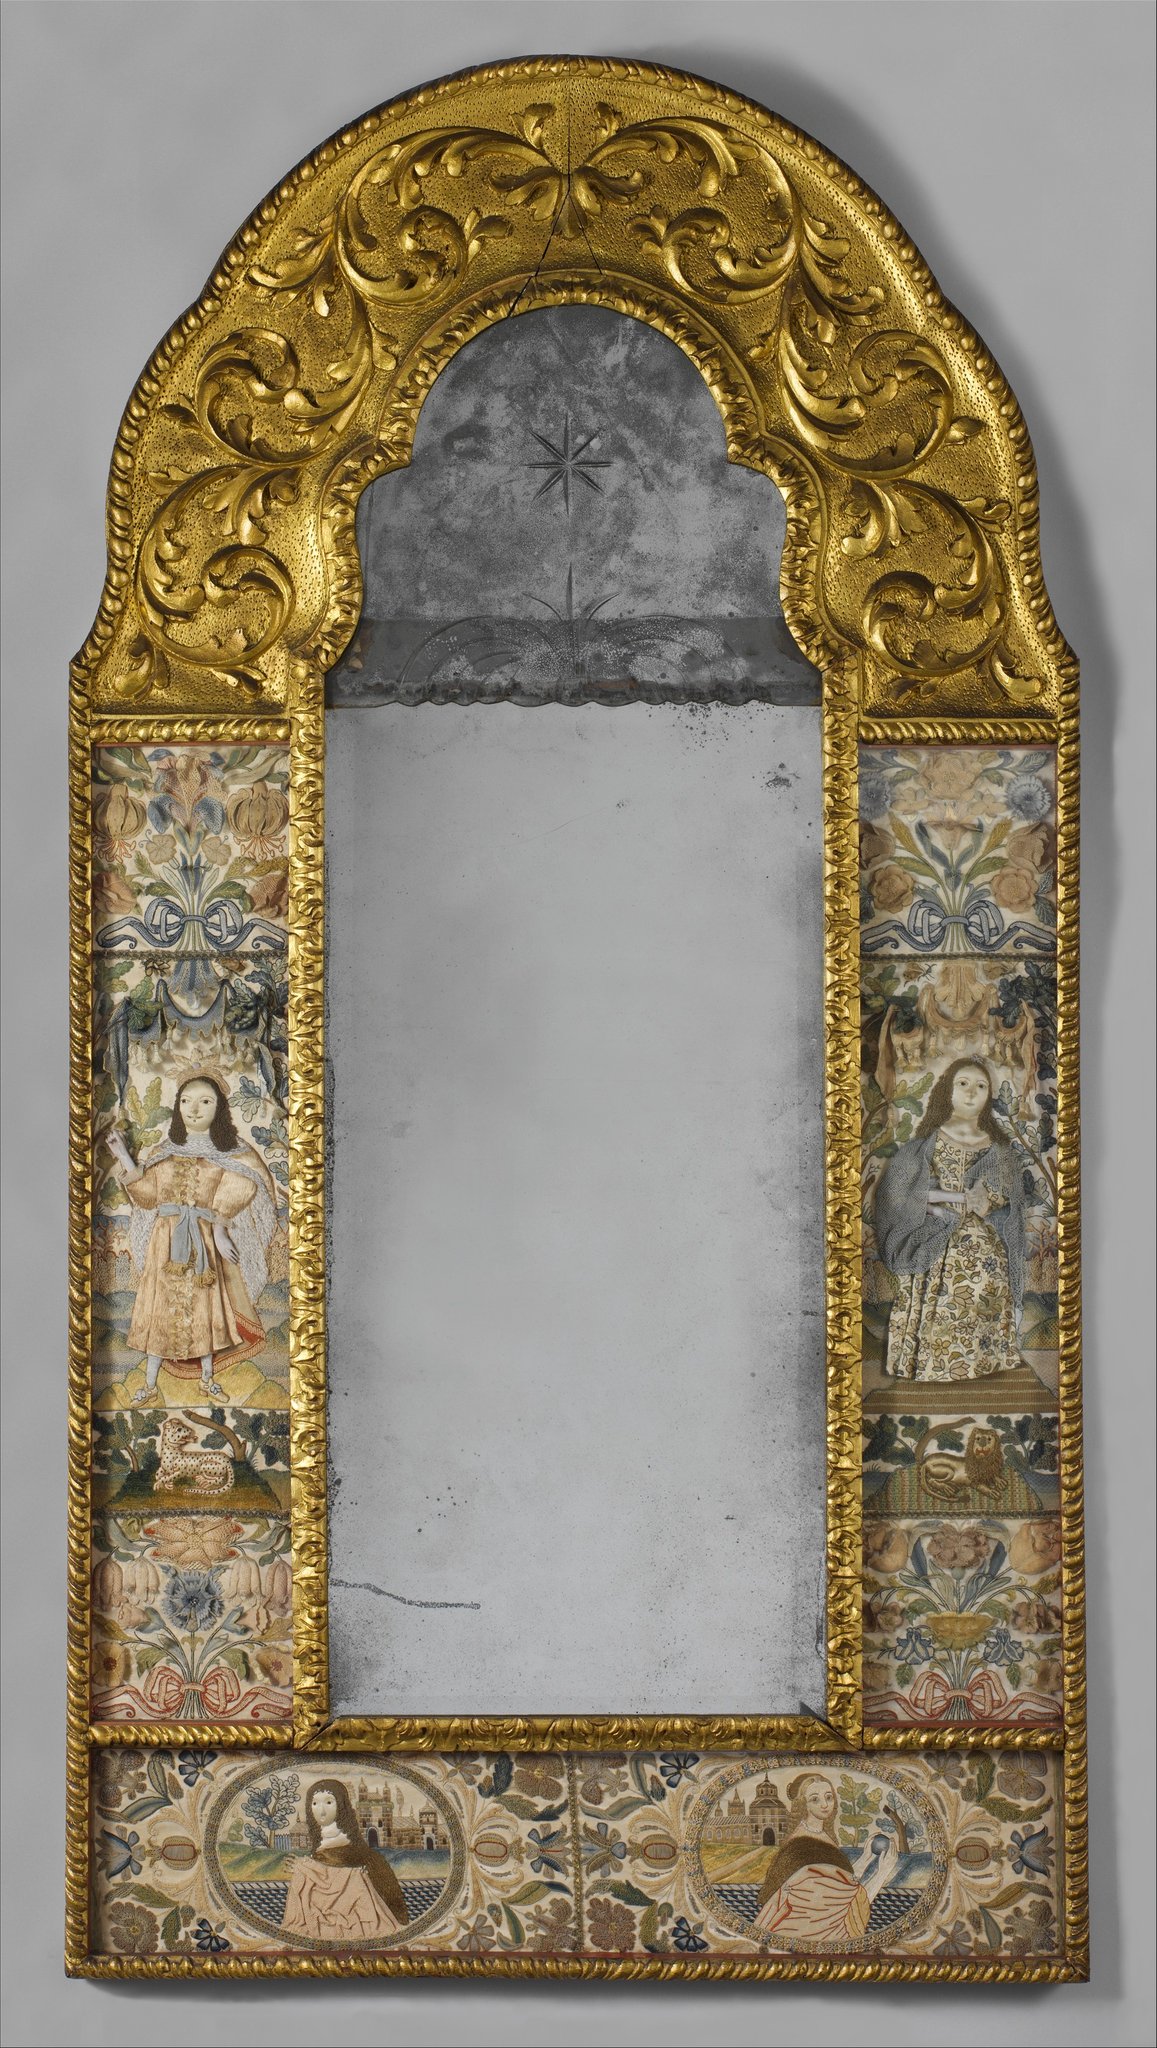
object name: mirror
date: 1651-1675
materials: textile, silk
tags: men,women,leopards,lions